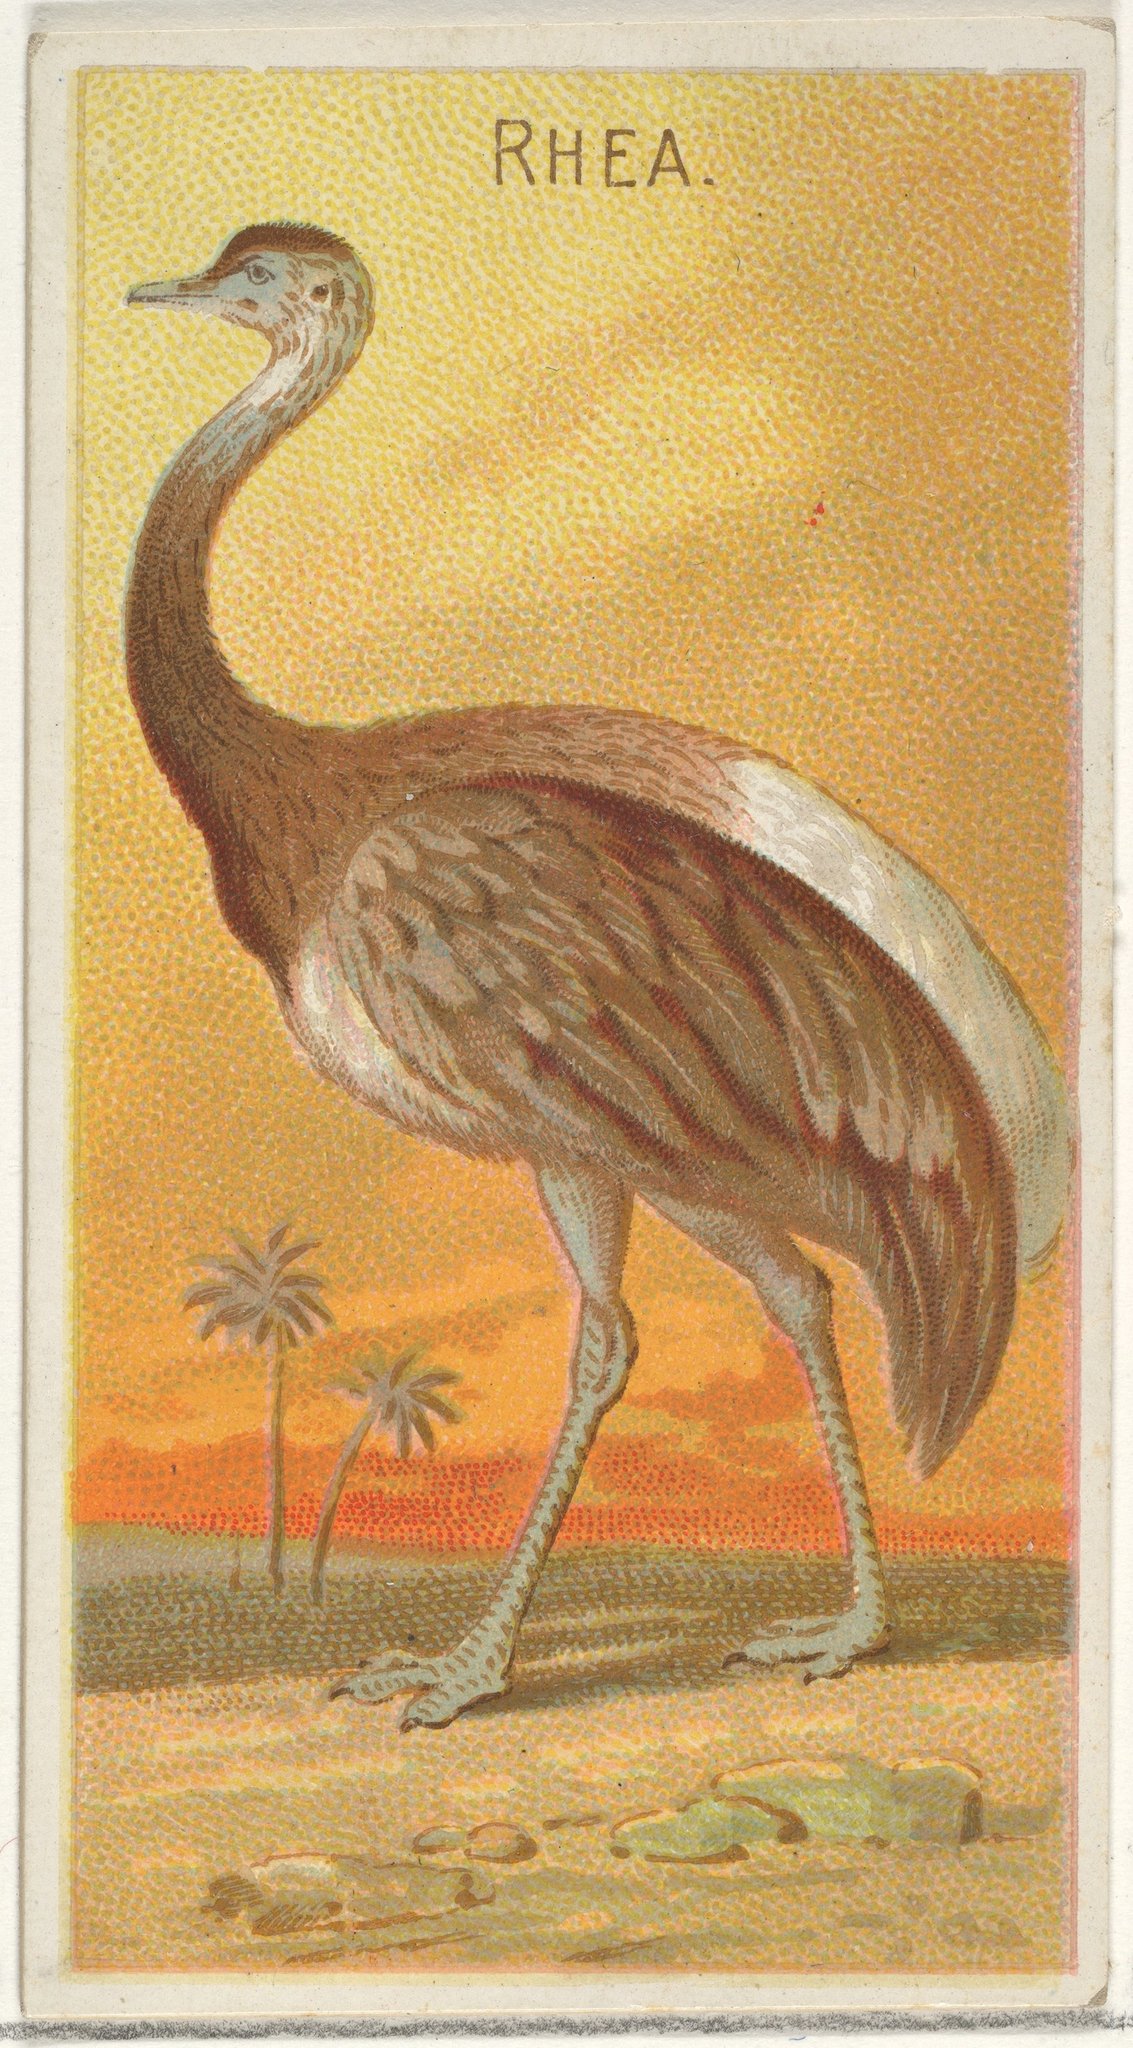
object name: print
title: Rhea, from the Birds of the Tropics series (N5) for Allen & Ginter Cigarettes Brands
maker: allen & ginter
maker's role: publisher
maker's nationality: american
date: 1889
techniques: color lithograph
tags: birds